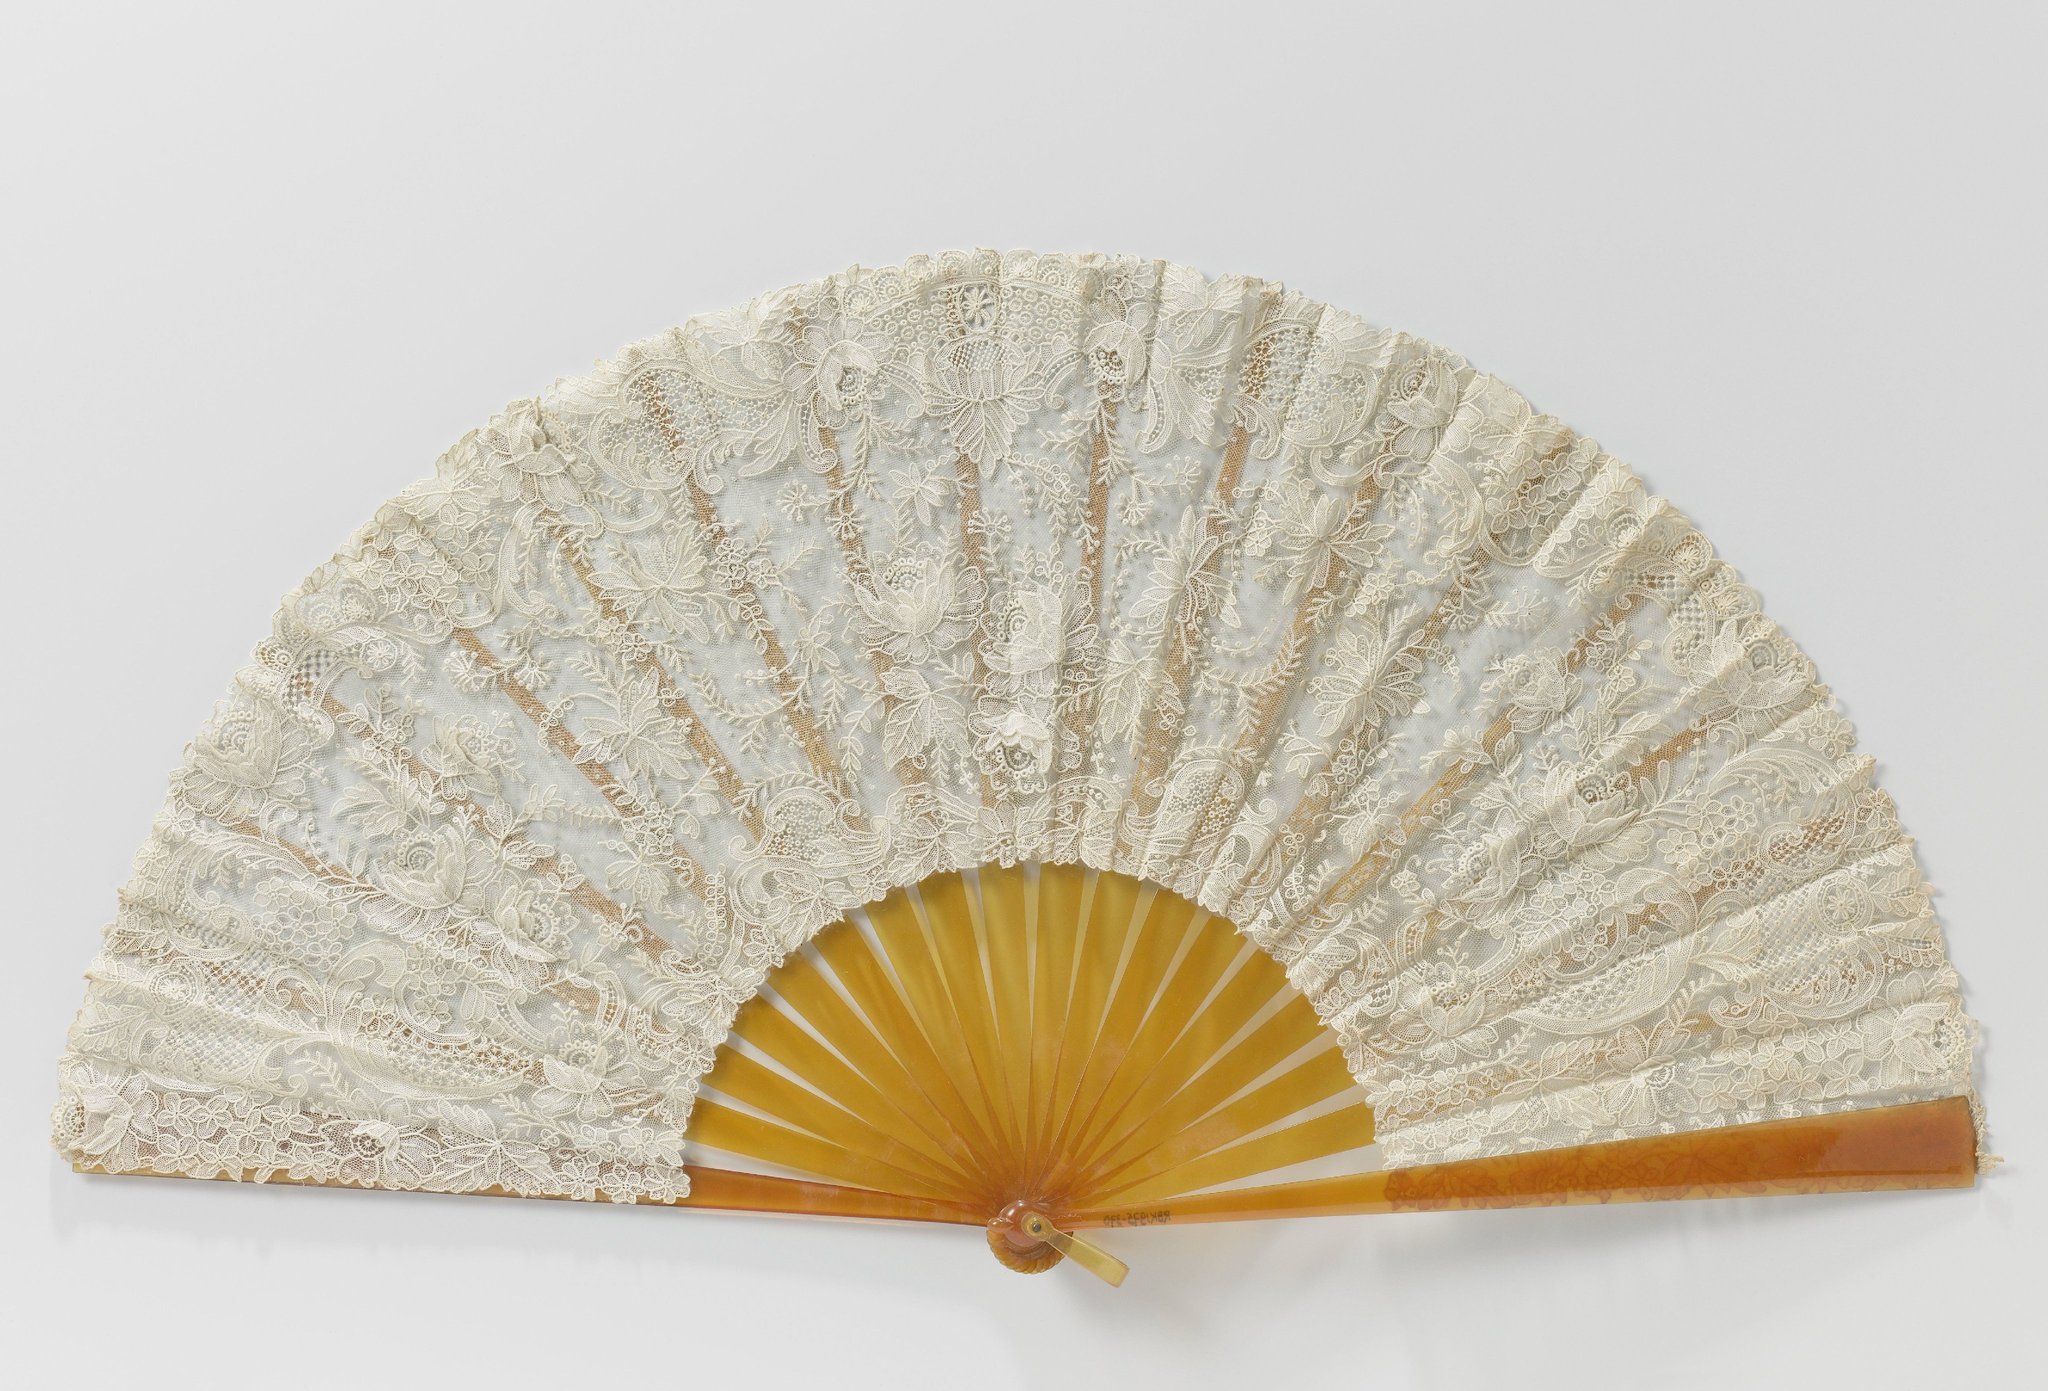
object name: vouwwaaier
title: Vouwwaaier met een blad van naaldkant met rozen, takken en bladrocaillemotieven op een montuur van blond schildpad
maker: Anonymous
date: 1850-1860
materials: shell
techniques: needle lace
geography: brussels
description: Het steundeel van het montuur is ajour gesneden. Vouwwaaier met een blad van naaldkant met rozen, takken en bladrocaillemotieven op een montuur van blond schildpad.